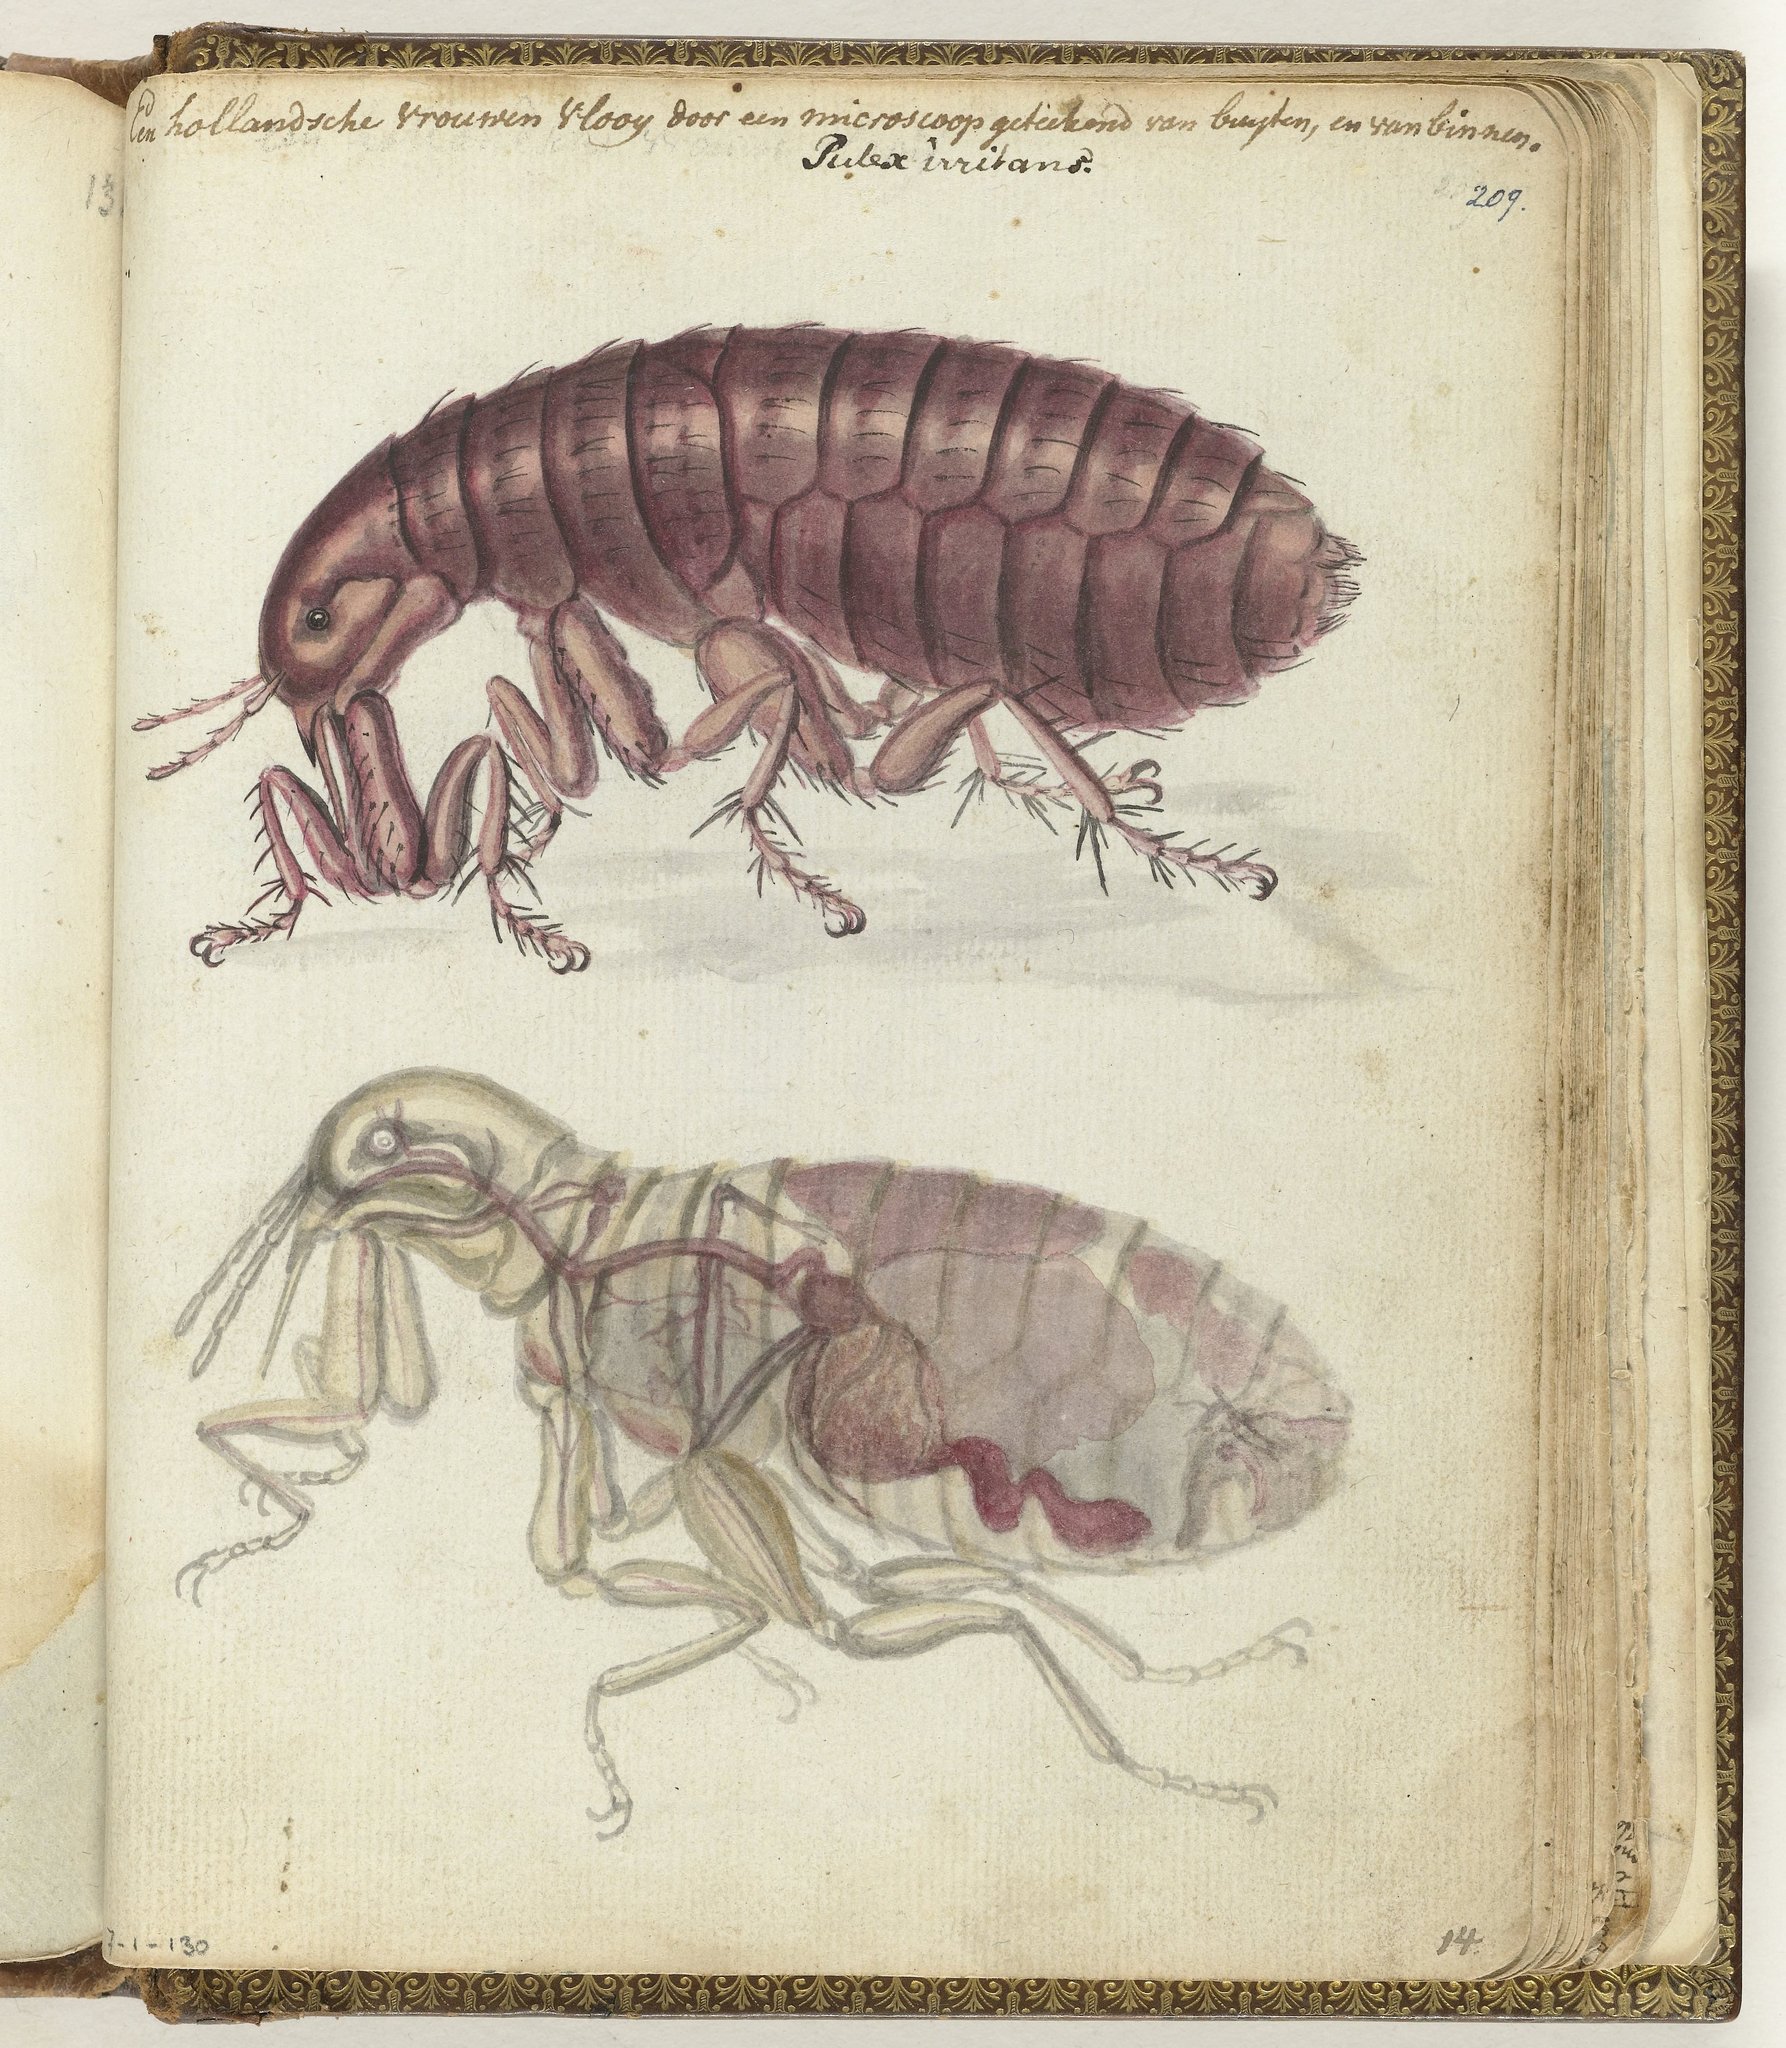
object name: drawing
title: Hollandse vrouwenvlooi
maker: jan brandes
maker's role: draughtsman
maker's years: 1743-1808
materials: paper, pencil, watercolor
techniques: brush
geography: netherlands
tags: insects: flea, netherlands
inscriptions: inscription: ‘Een hollandsche vrouwen vlooy door een microscoop geteekend van buyten, en van binnen. Pulex irritans.’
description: Kleurtekening van een Hollandse vrouwenvlooi 'door een microscoop getekend van buijten, en van binnen' (waarbij de organen zichtbaar zijn). Met opschrift. Onderdeel uit het schetsboek van Jan Brandes, dl. 1 (1808), p. 209.